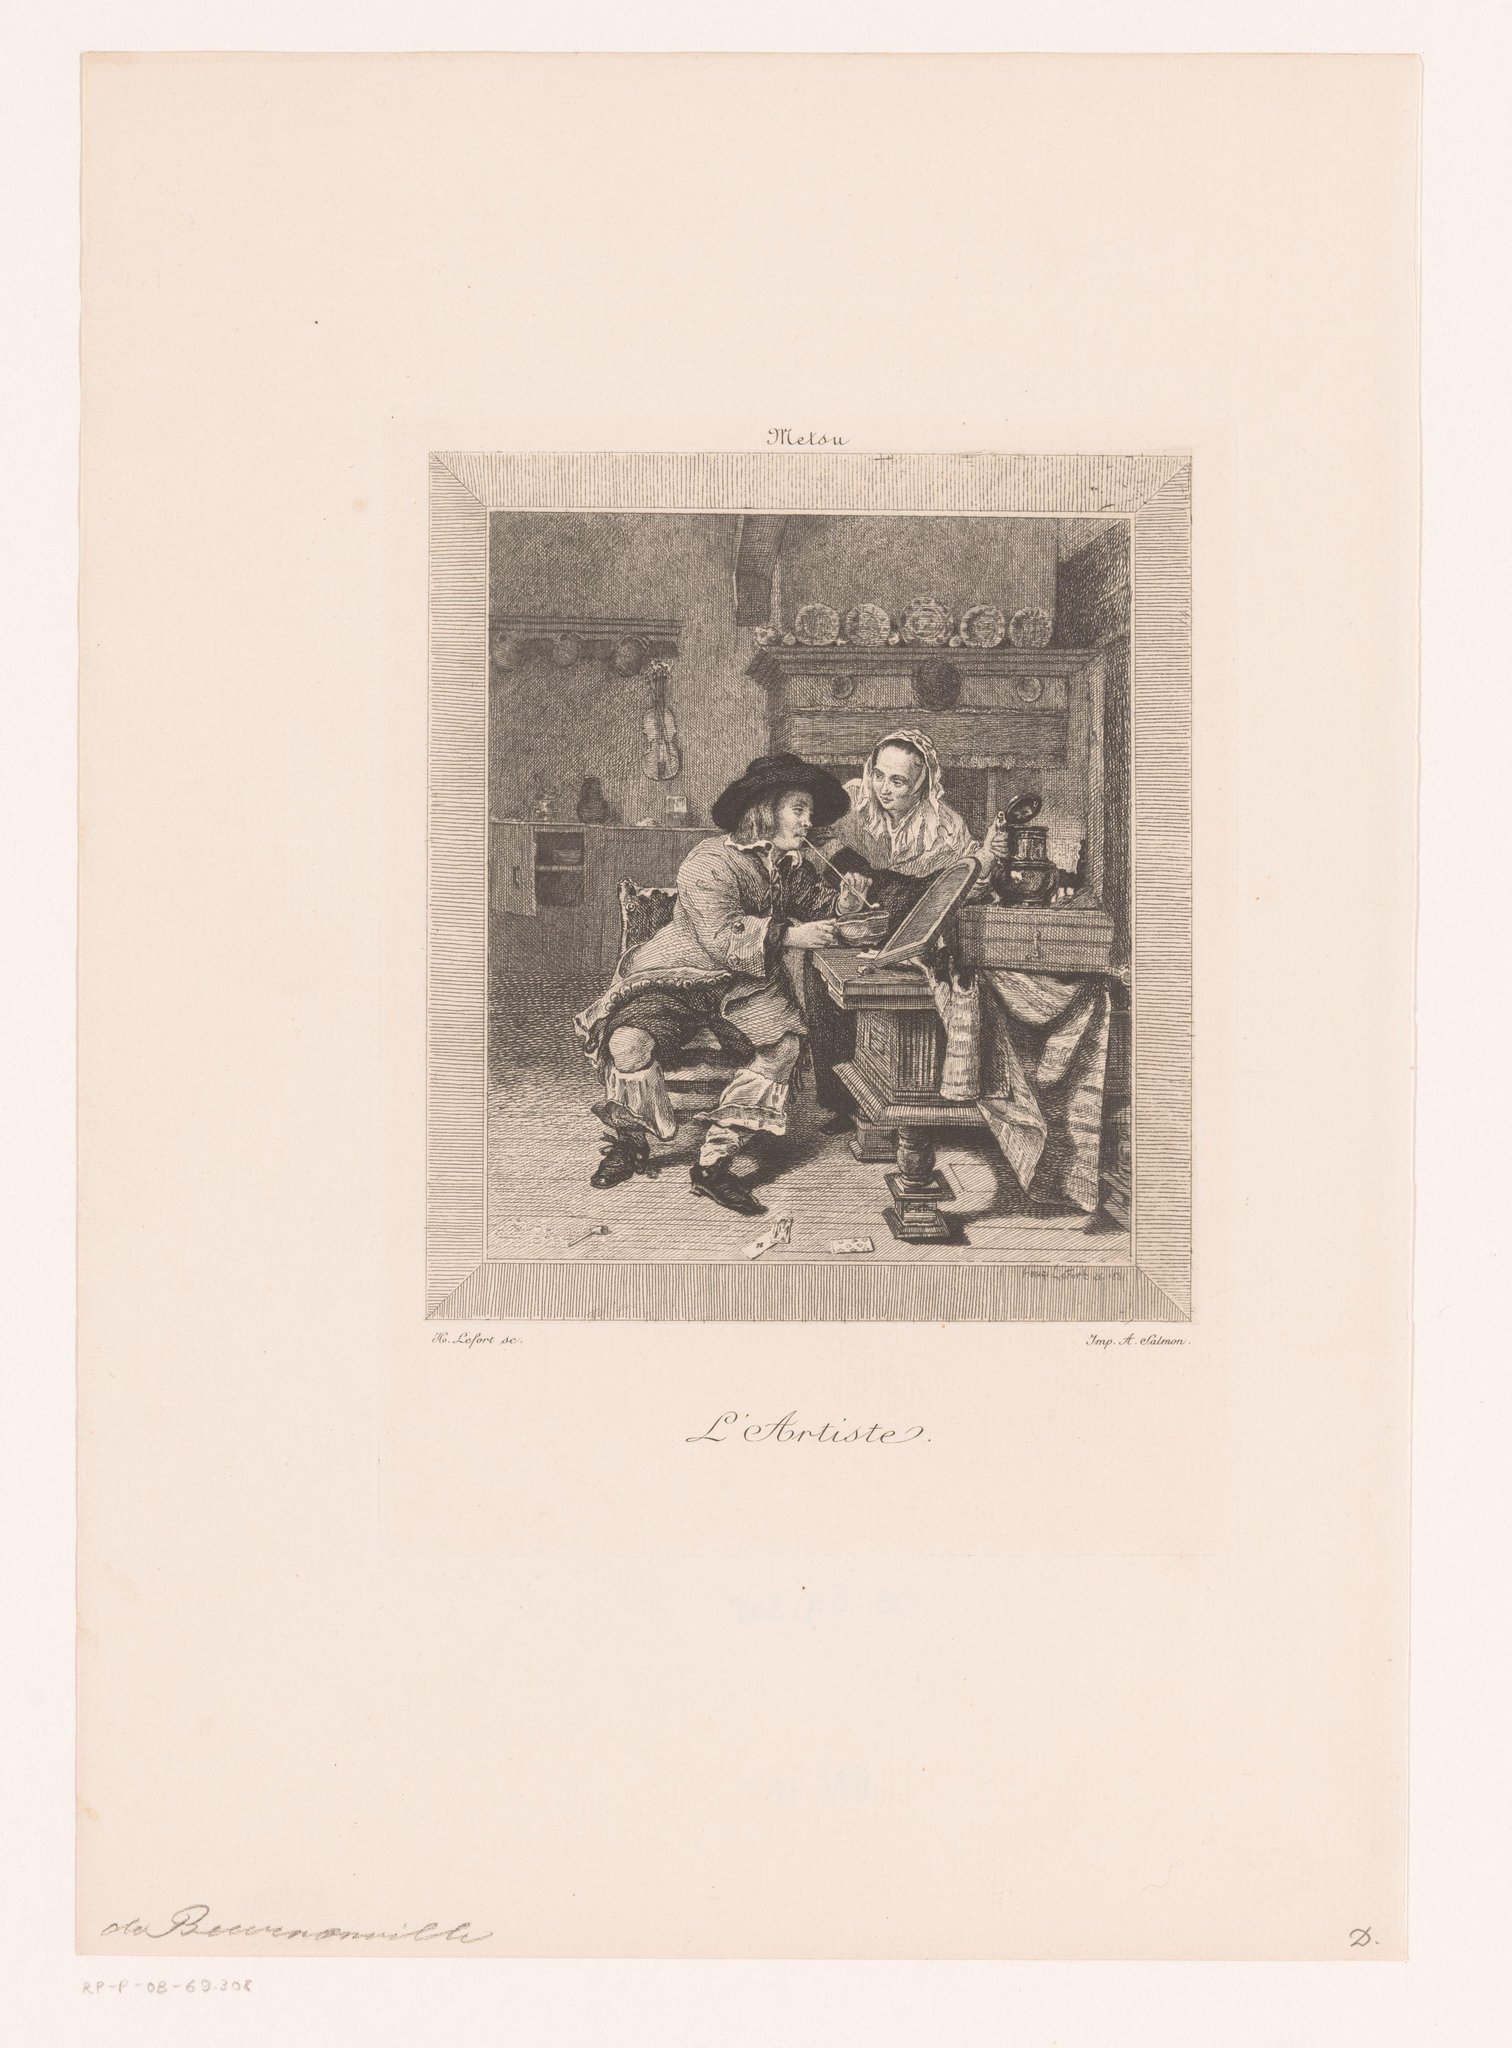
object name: print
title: Interieur met een man met pijp en een staande vrouw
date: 1881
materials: paper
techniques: etching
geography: paris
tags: the artist and his family, relatives, etc., interior of the house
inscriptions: collector's mark: Lugt 2228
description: Gepubliceerd in de veilingcatalogus van Beurnonville, 1881.